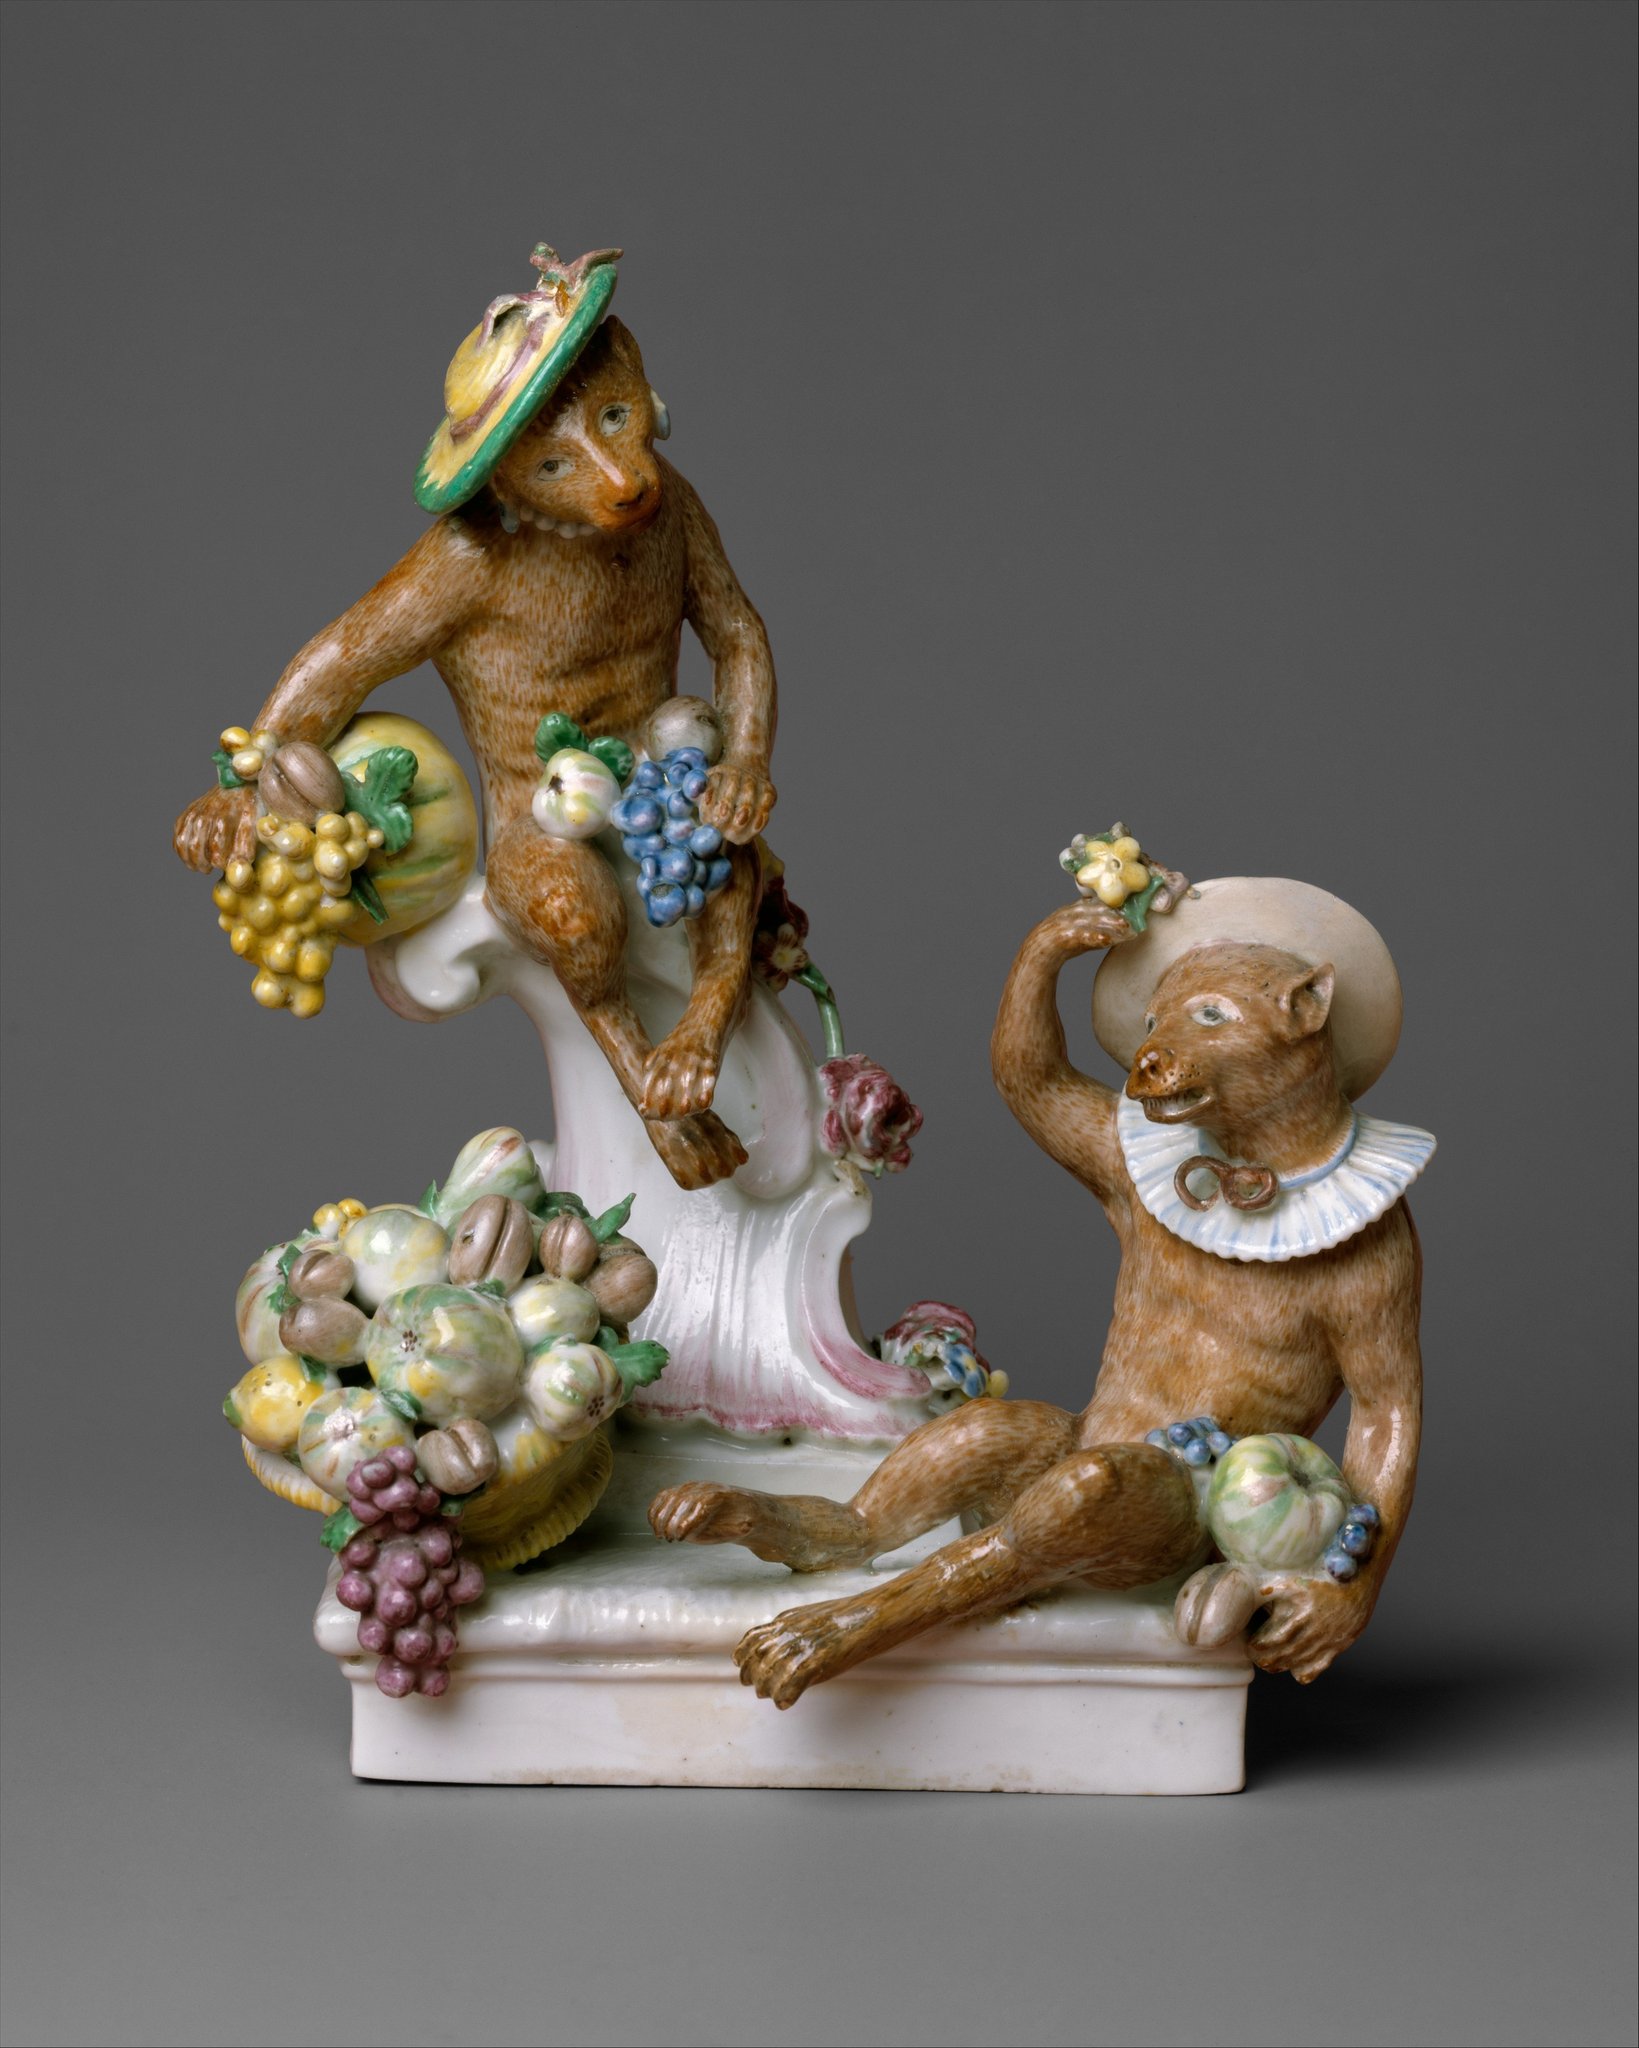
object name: group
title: Monkeys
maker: gardner manufactory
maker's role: manufactory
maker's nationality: russian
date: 1770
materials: hard paste porcelain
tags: fruit,monkeys